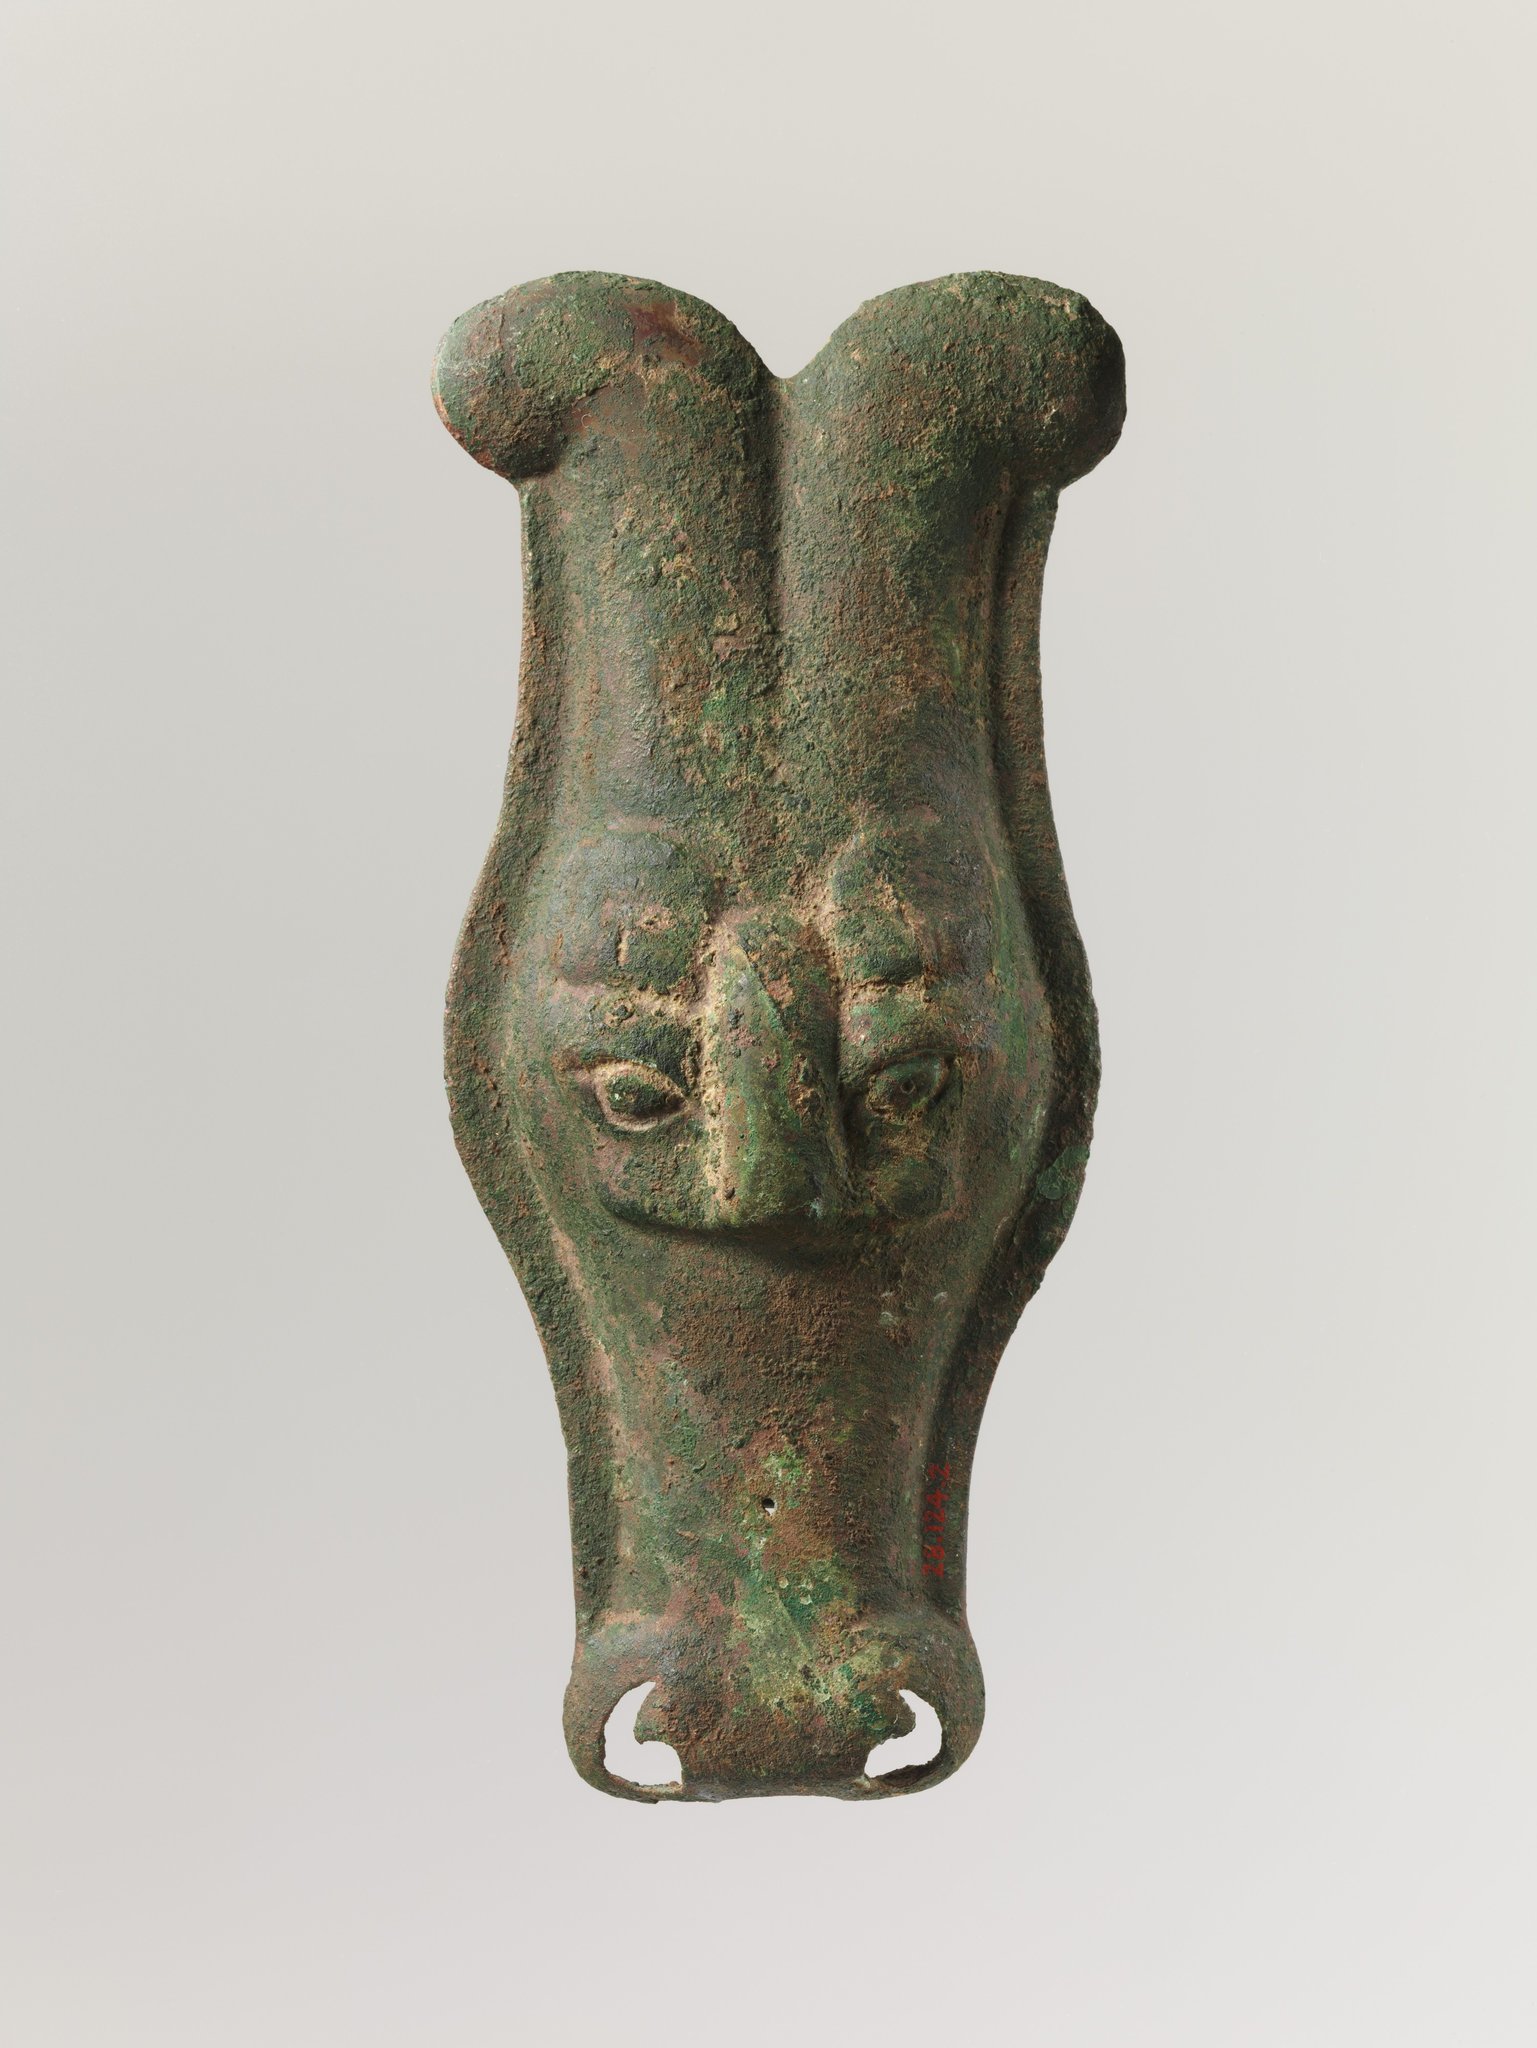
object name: frontlet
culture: chinese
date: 1046-771 BCE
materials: bronze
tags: masks